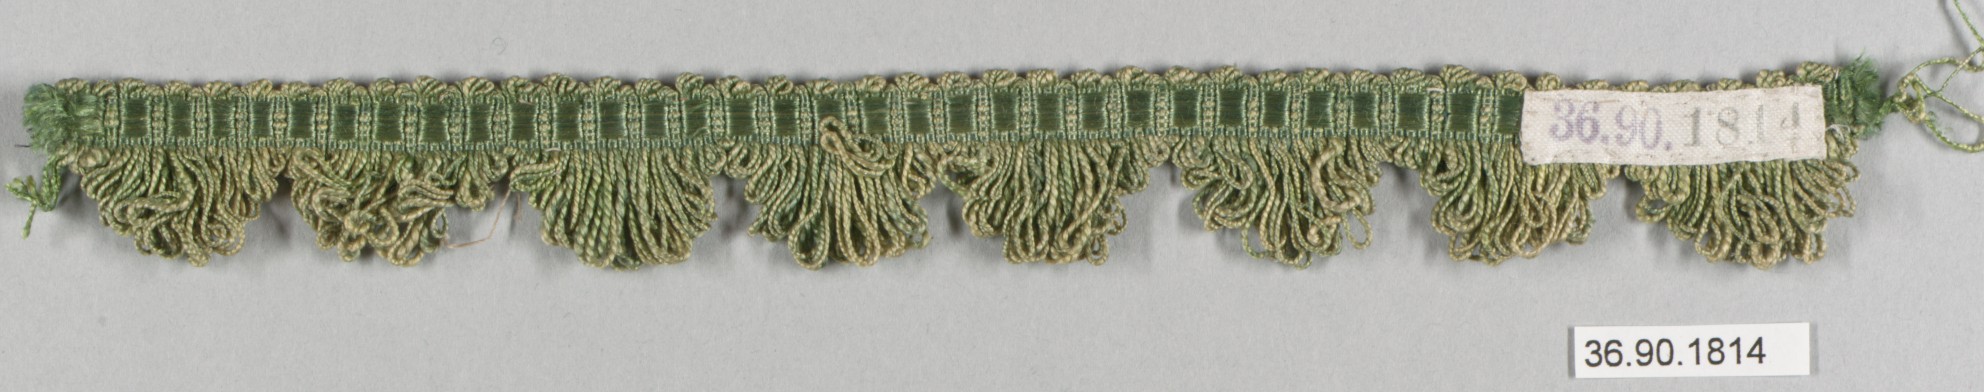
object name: fringe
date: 1701-1800